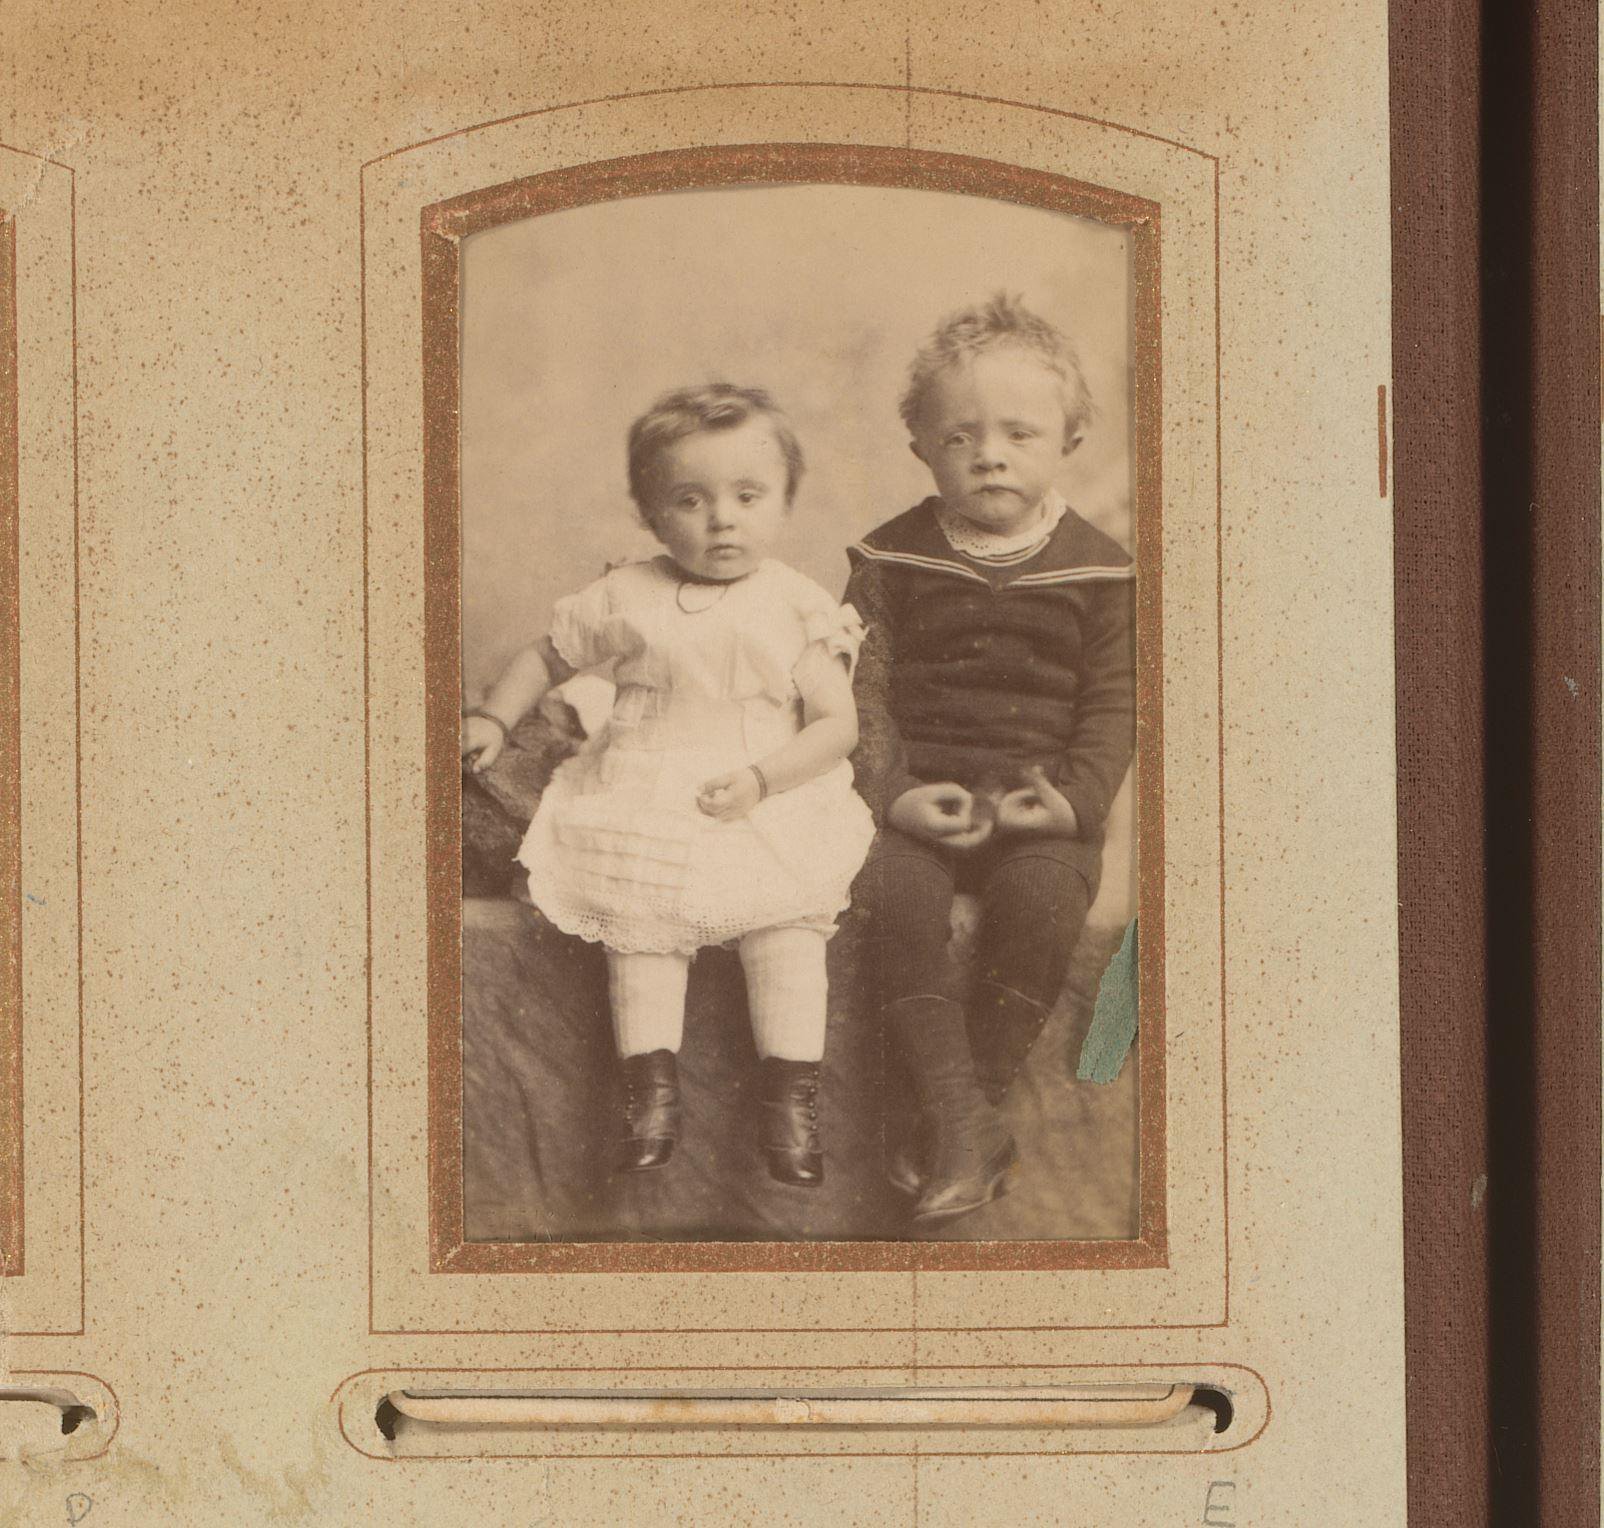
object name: carte de visite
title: Portret van twee zittende peuters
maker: albert greiner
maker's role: fotograaf, fotostudio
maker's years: 1833-1890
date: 1861-1890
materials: cardboard, photographic support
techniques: albumen print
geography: amsterdam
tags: sitting figure, tot, toddler ~ the ages of man (+ two persons), historical persons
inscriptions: inscription: ‘A. Greiner - Amsterdam./ KONINKLIJKE HOF PHOTOGRAAF.’, annotation: ‘bl II/ Jo[han] [en] P[..]line/ te/ Le[...]bin[.]’, inscription: ‘PROEFKAART/ A. GREINER’